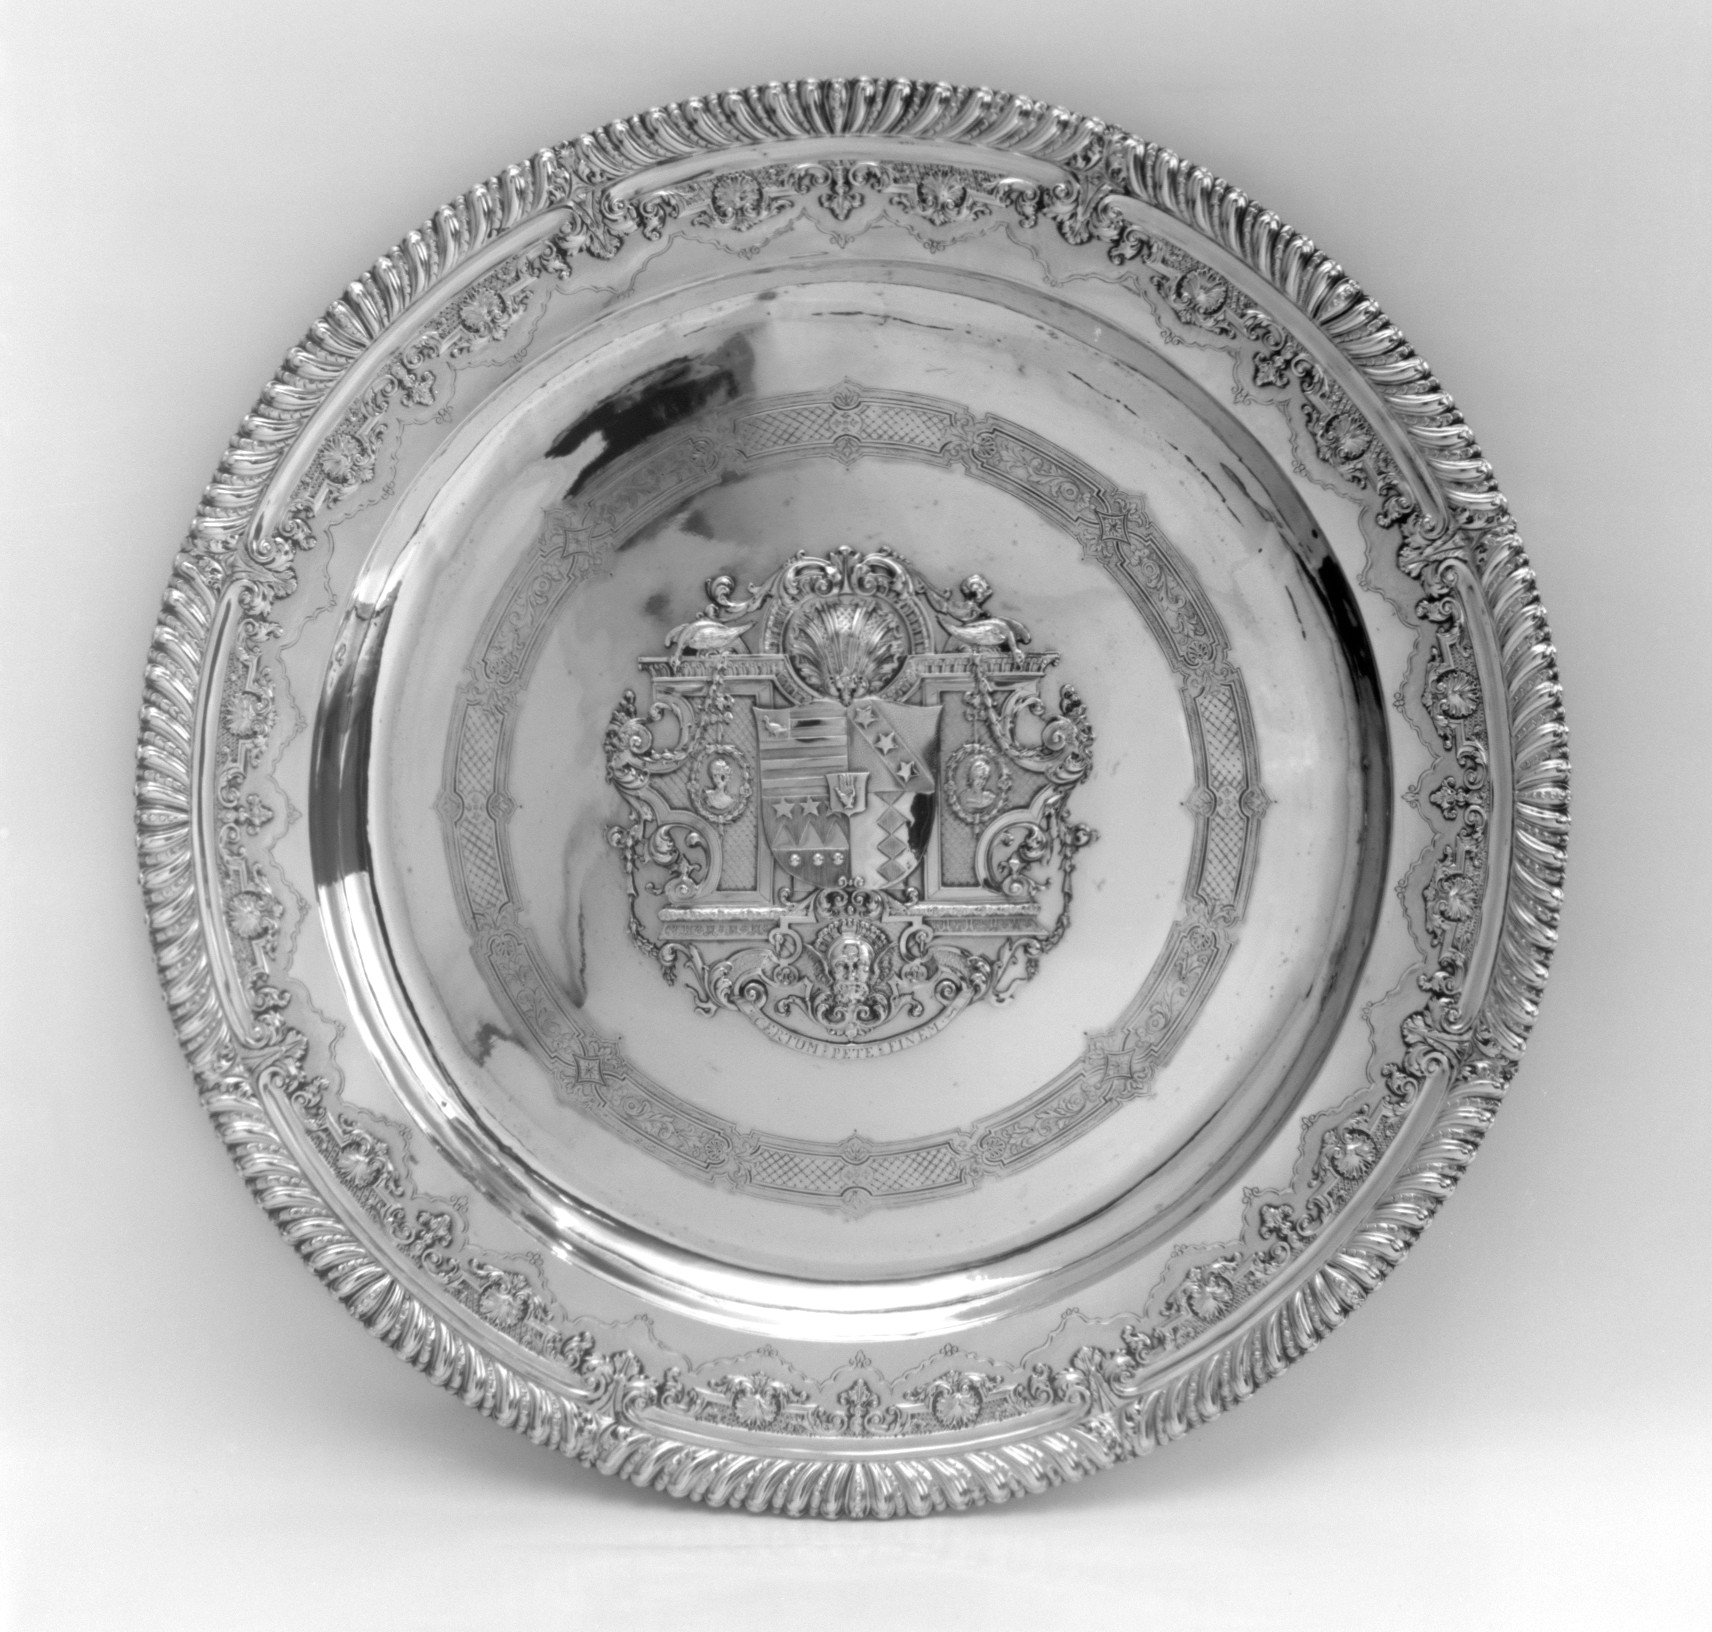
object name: charger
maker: paul de lamerie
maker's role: maker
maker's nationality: british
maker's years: 1688-1751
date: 1723-1724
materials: silver gilt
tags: coat of arms